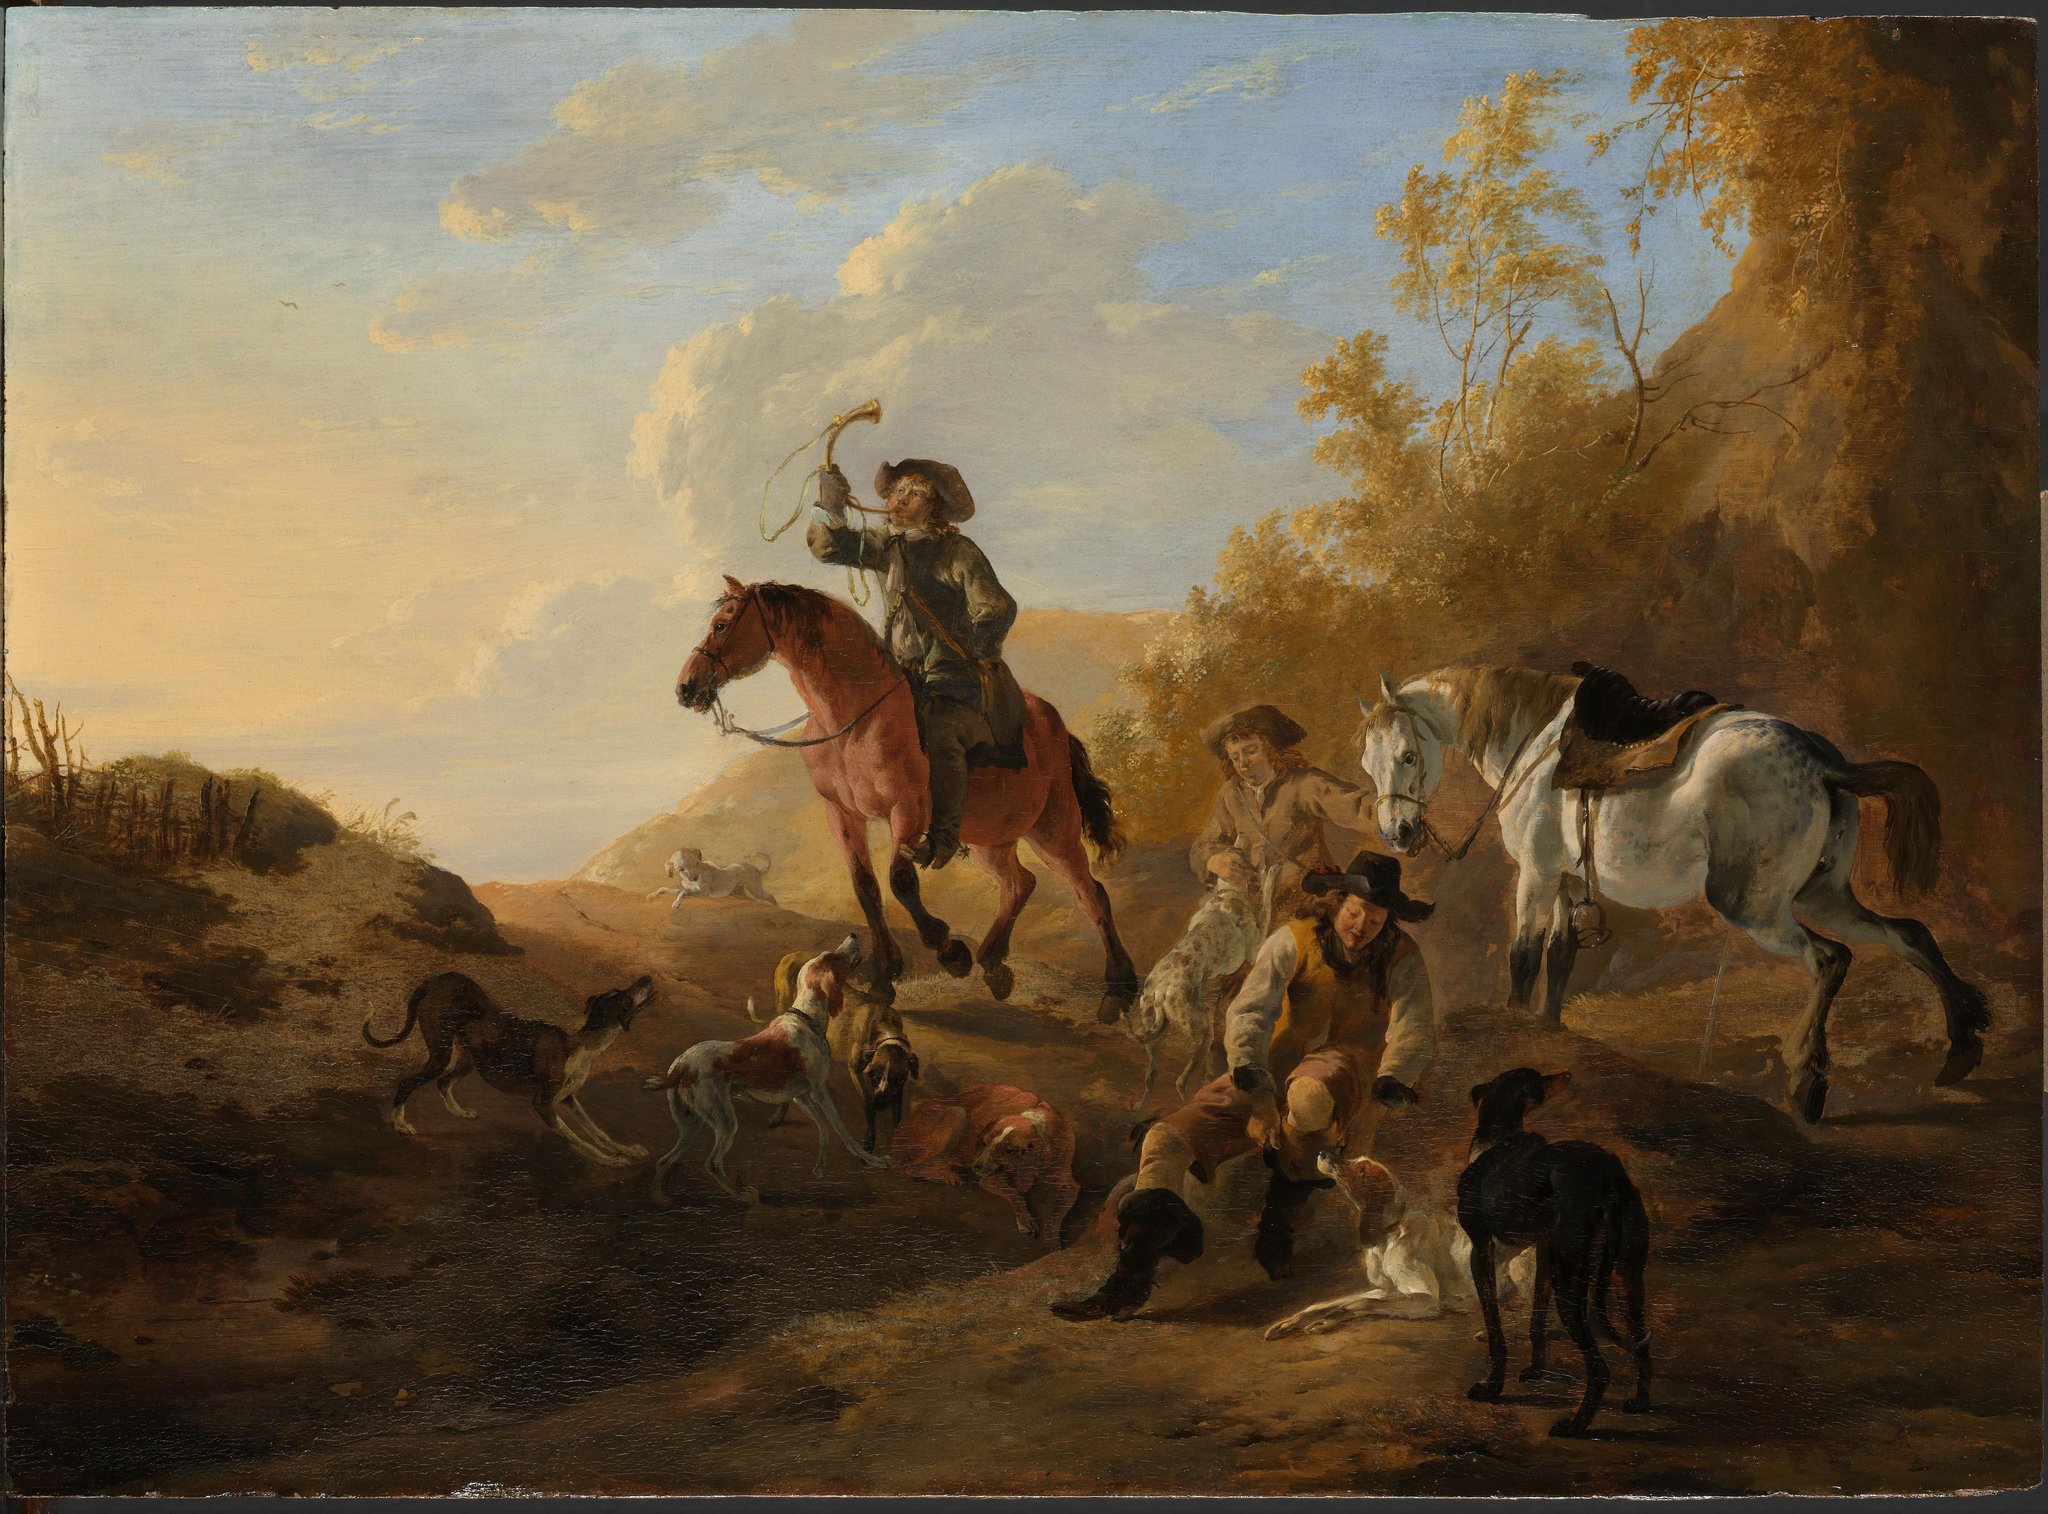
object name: painting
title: Hunters resting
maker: dirk stoop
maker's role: draughtsman, painter, print maker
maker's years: 1615-1686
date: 1650-1655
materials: oil, panel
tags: hunting dogs, blowing the hunting horn, hunters resting during the hunt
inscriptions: signature: ‘D. Stoop’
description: Two hunters and their hounds have stopped in a mountainous landscape. The horseman blows his hunting horn, signalling their departure. His companion pulls on his boots, while a servant holds on to a pissing horse. The rich brown tones and the golden light of the low-lying sun suggest a warm summer day. The use of such colours was typical of landscape painters who had travelled to Italy.